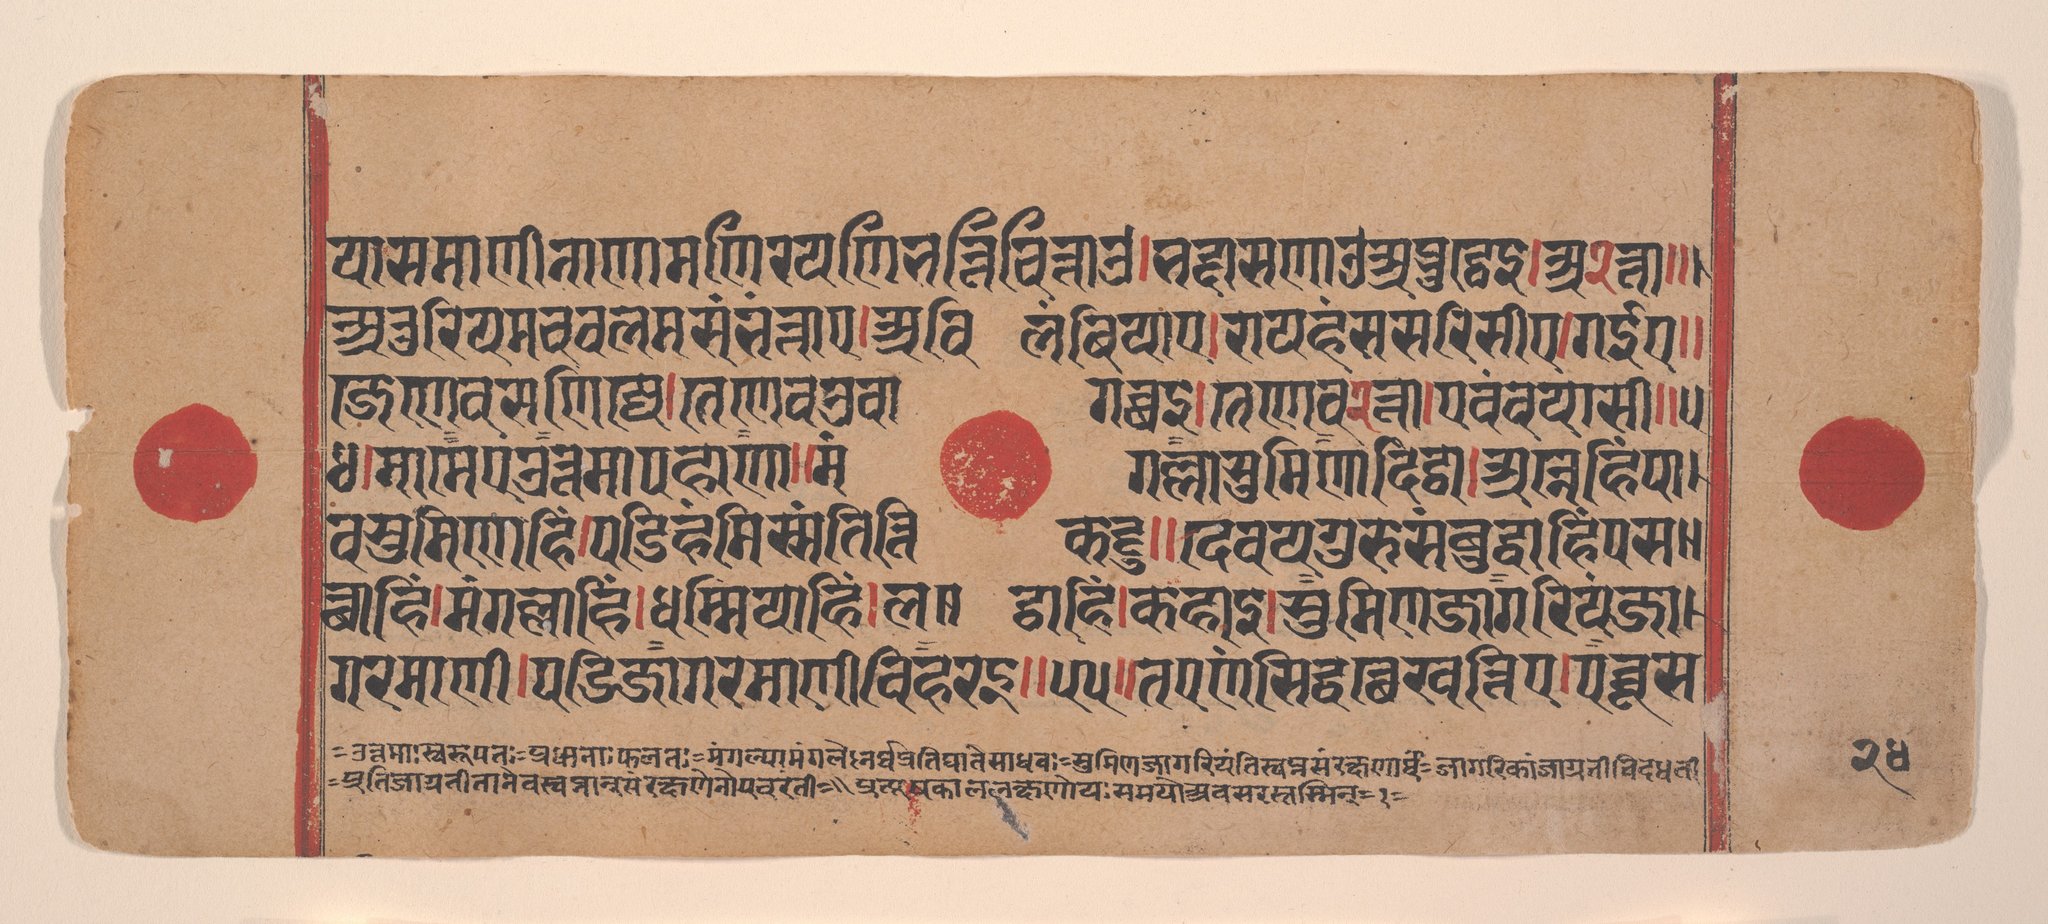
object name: folio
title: Page from a Dispersed Kalpa Sutra (Jain Book of Rituals)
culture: indian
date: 1401-1500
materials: gold, ink, paper, watercolor